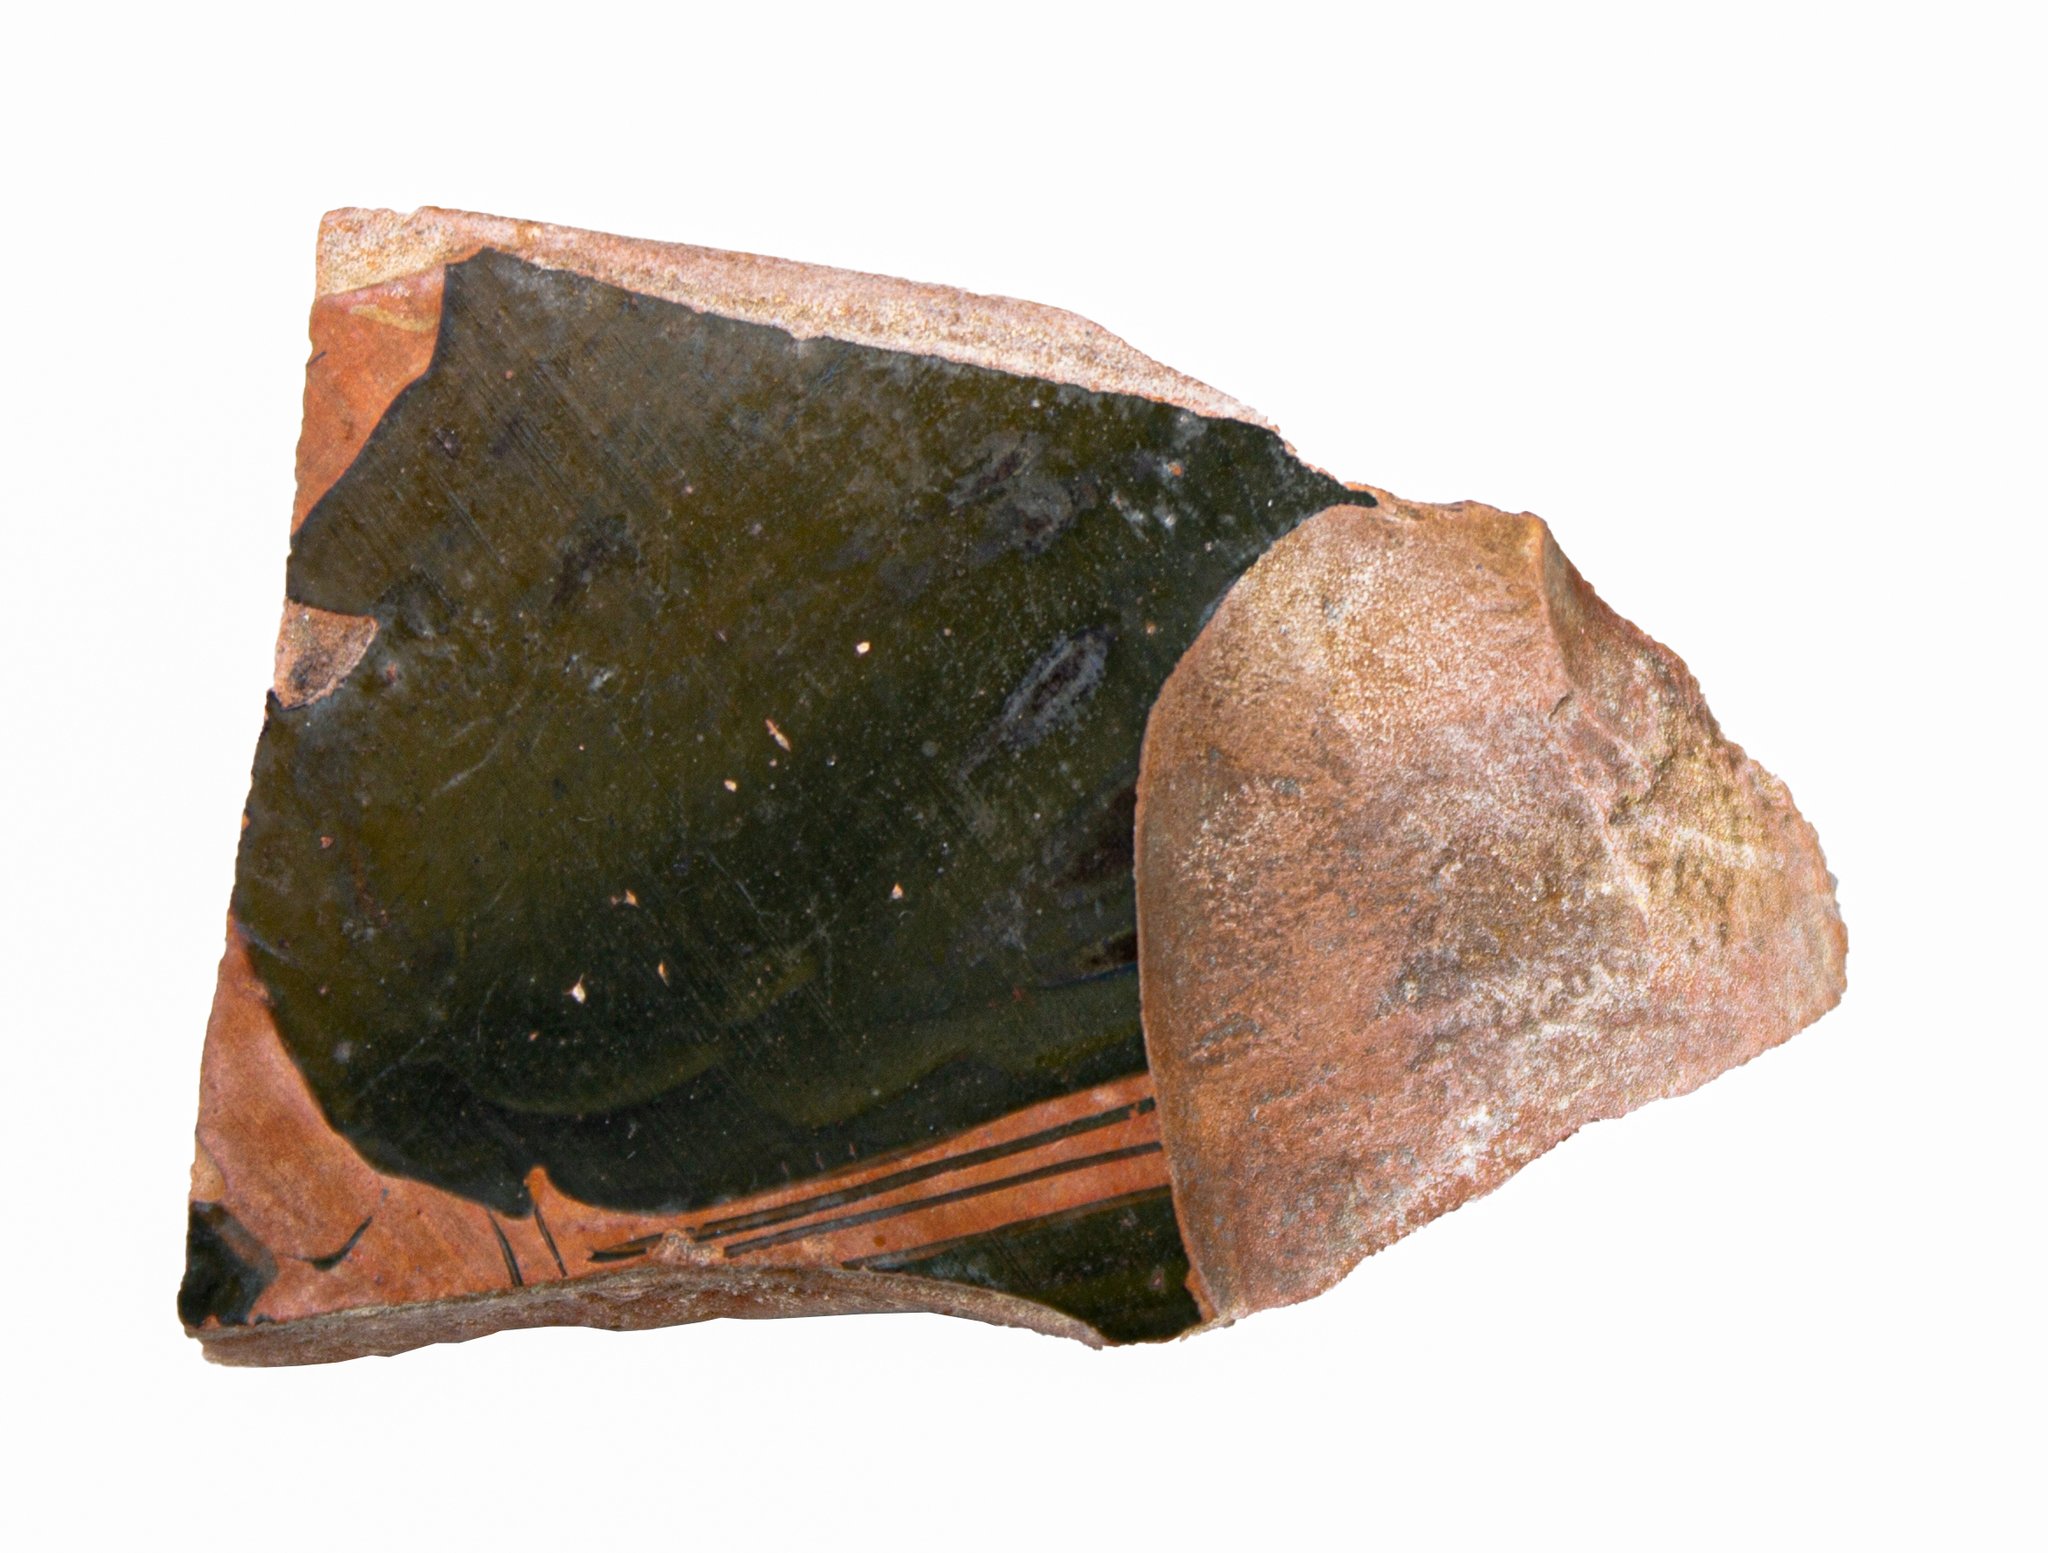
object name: volute krater fragment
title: Volute-krater fragment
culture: greek, south italian, apulian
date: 400-301 BCE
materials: terracotta